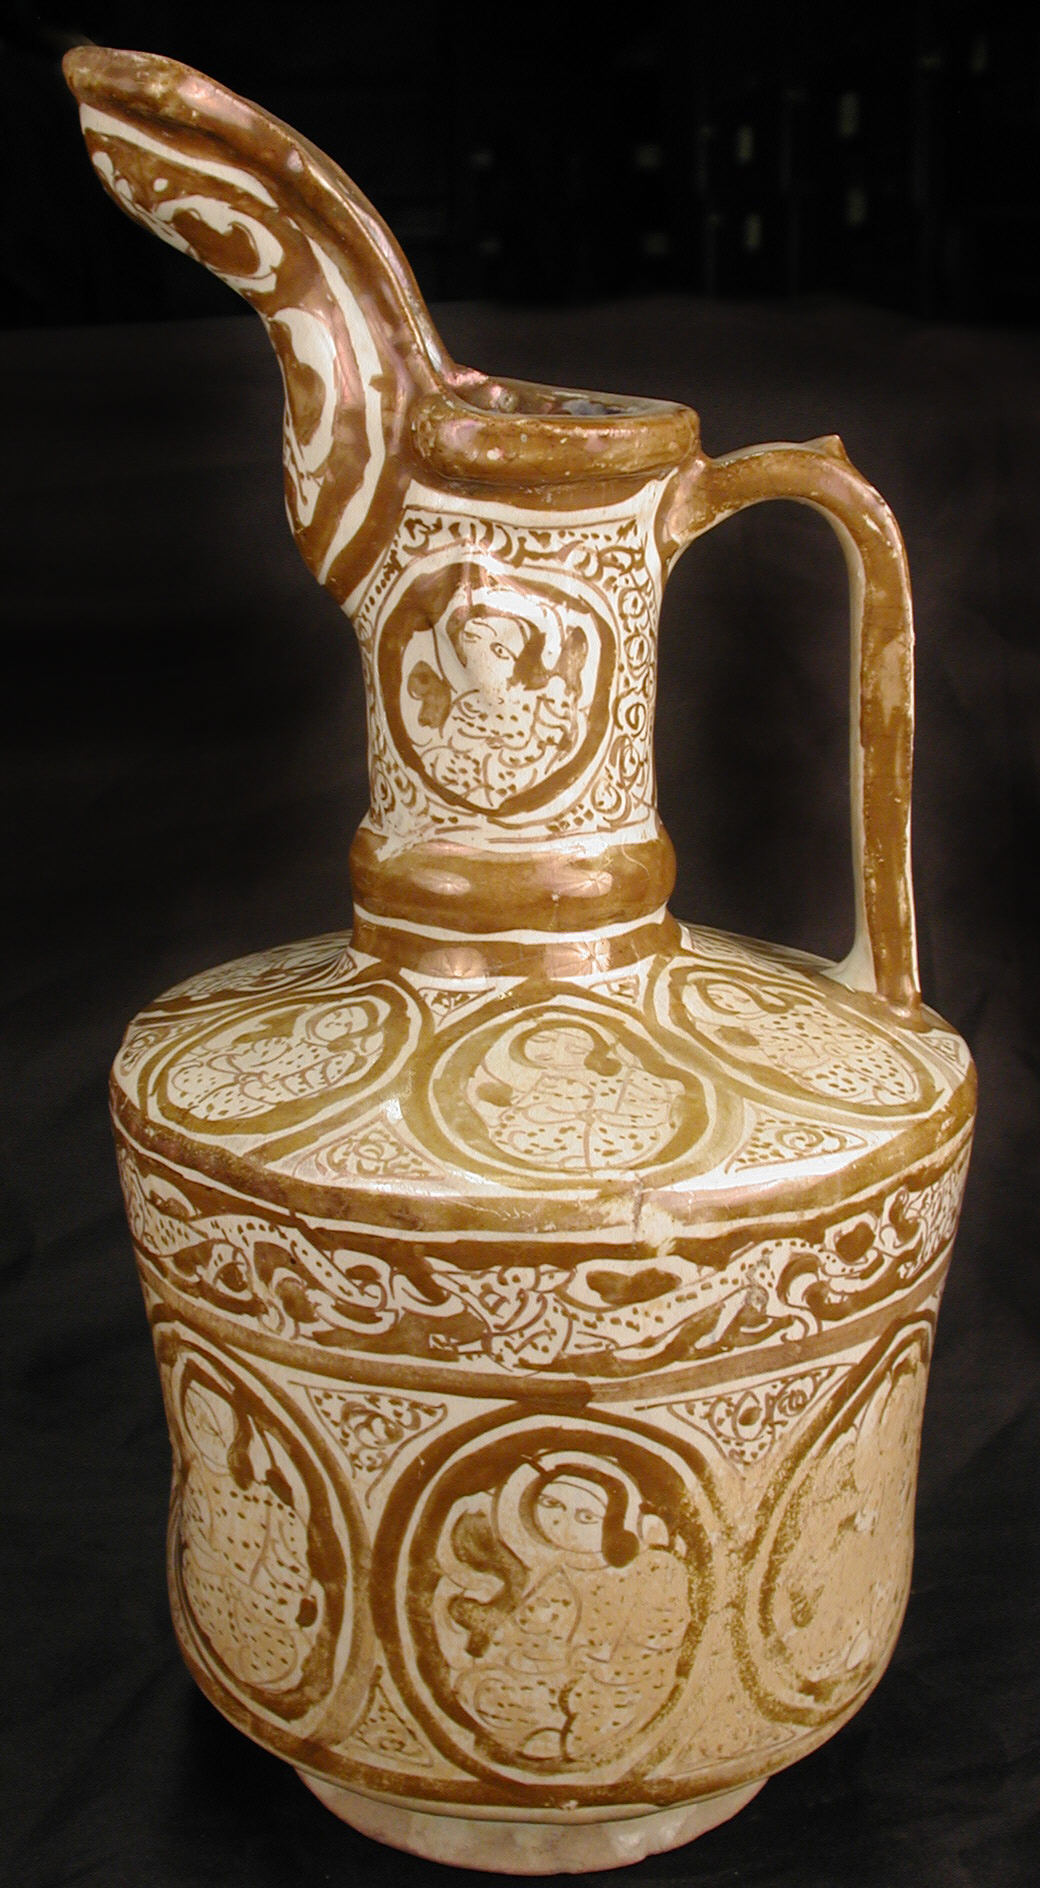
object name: ewer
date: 1101-1200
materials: earthenware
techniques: glazing, luster painting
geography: iran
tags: human figures